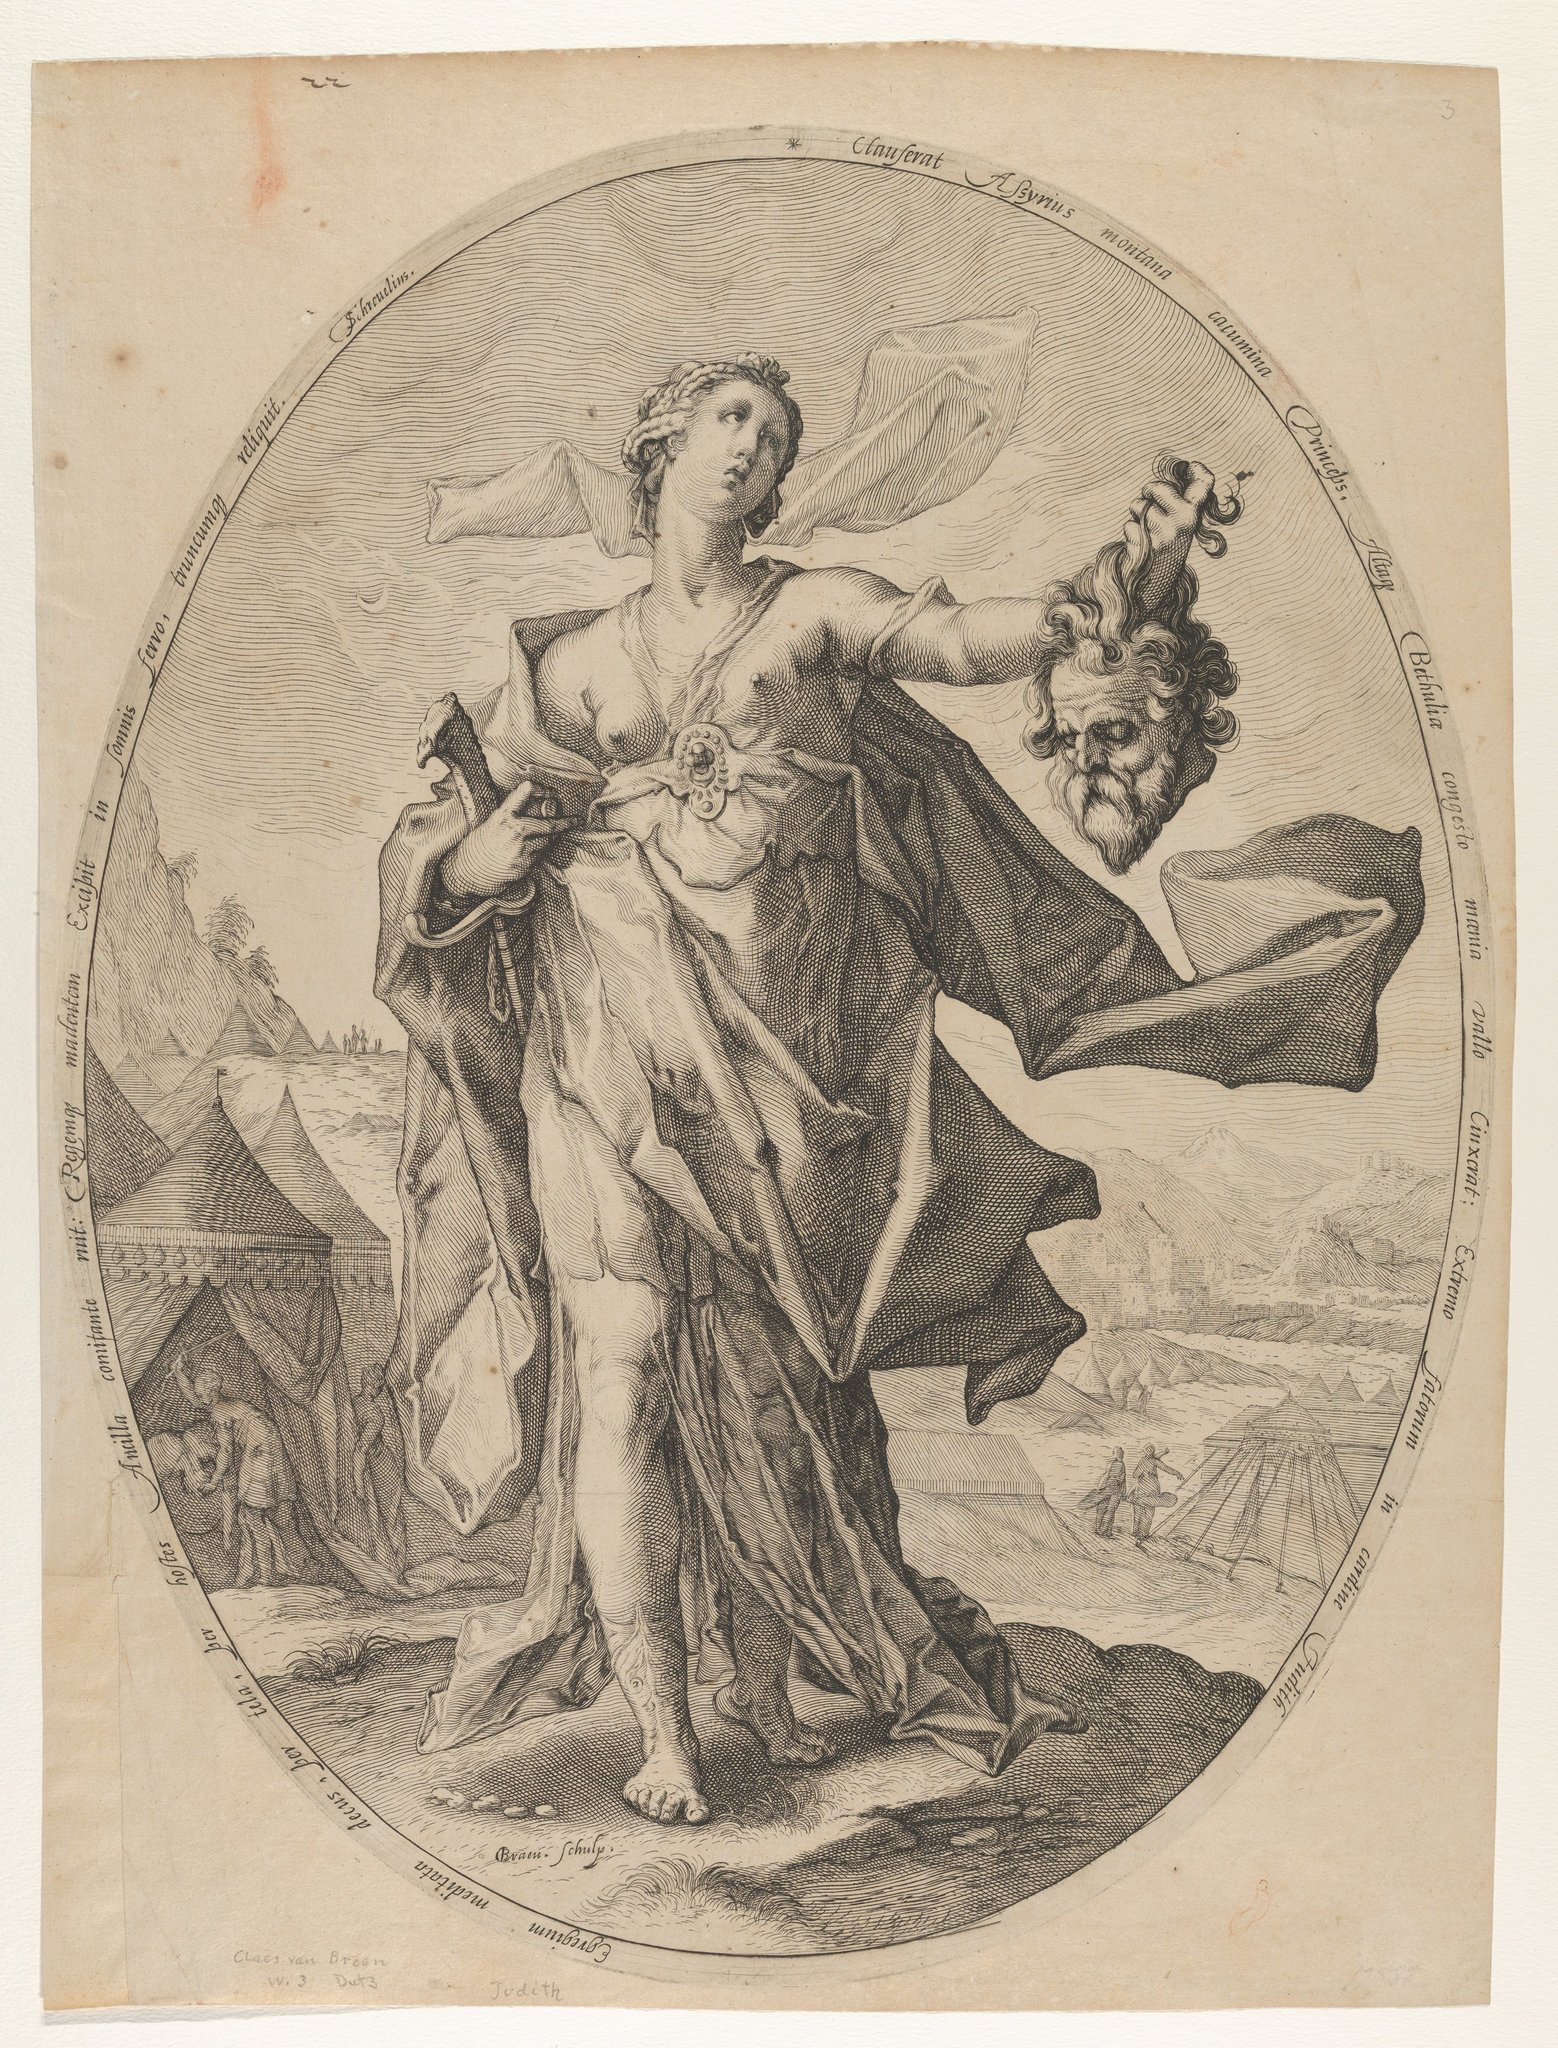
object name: print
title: Judith, from "Heroes and Heroines of the Old Testament"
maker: nicolaes braeu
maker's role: artist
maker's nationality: netherlandish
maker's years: 1586-1600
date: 1597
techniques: engraving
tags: heads,men,judith